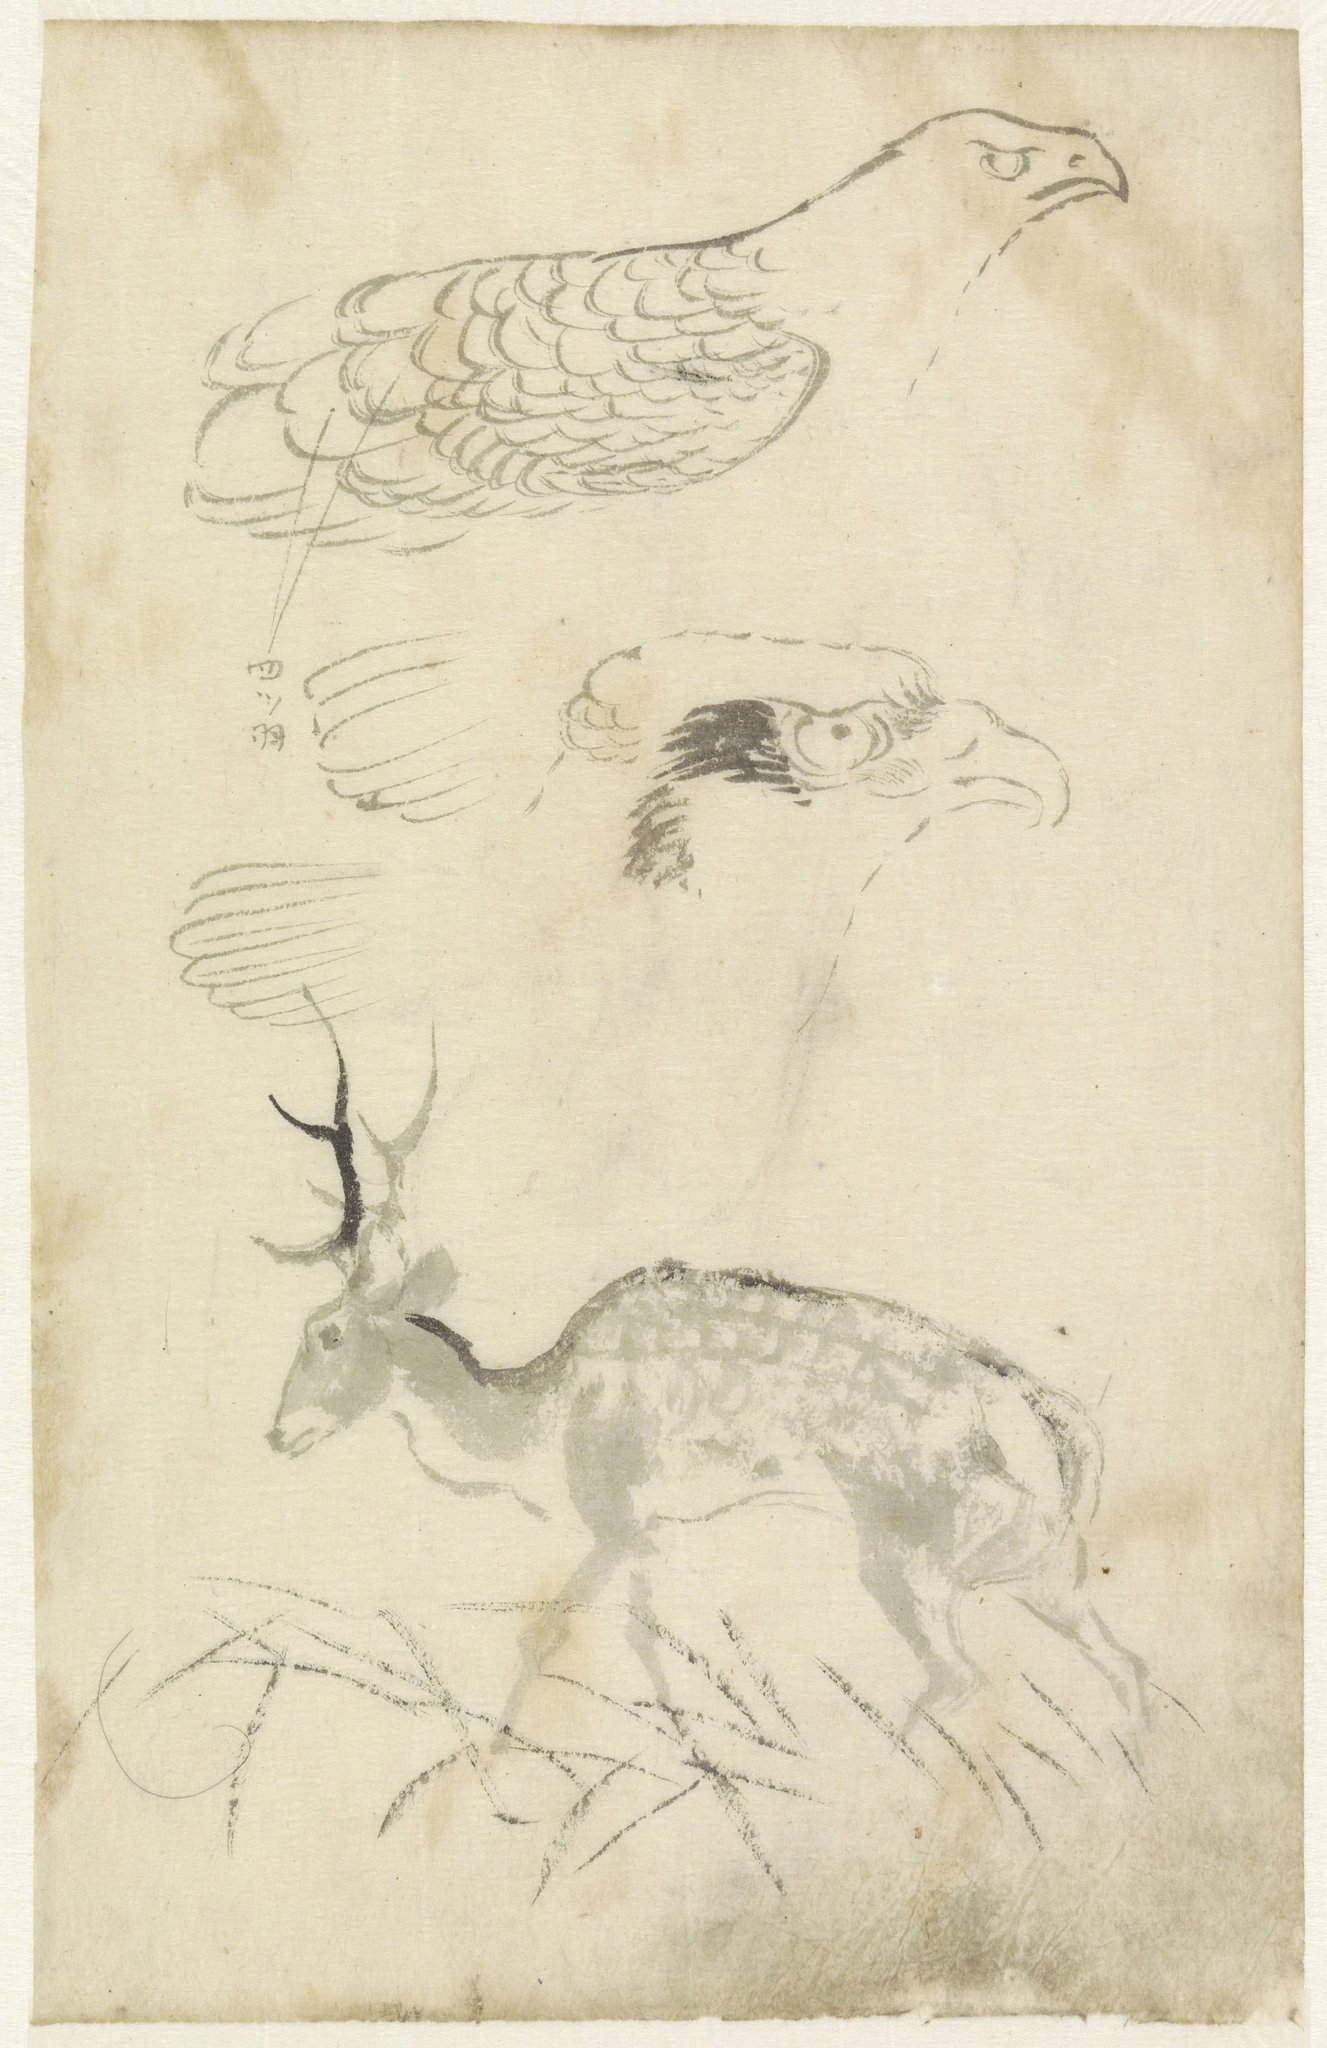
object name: drawing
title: Schetsblad met reebok in struikgewas en twee havikskoppen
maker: yamamoto shinryo baiitsu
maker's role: draughtsman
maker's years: 1789-1857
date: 1799-1857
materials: paper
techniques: brush